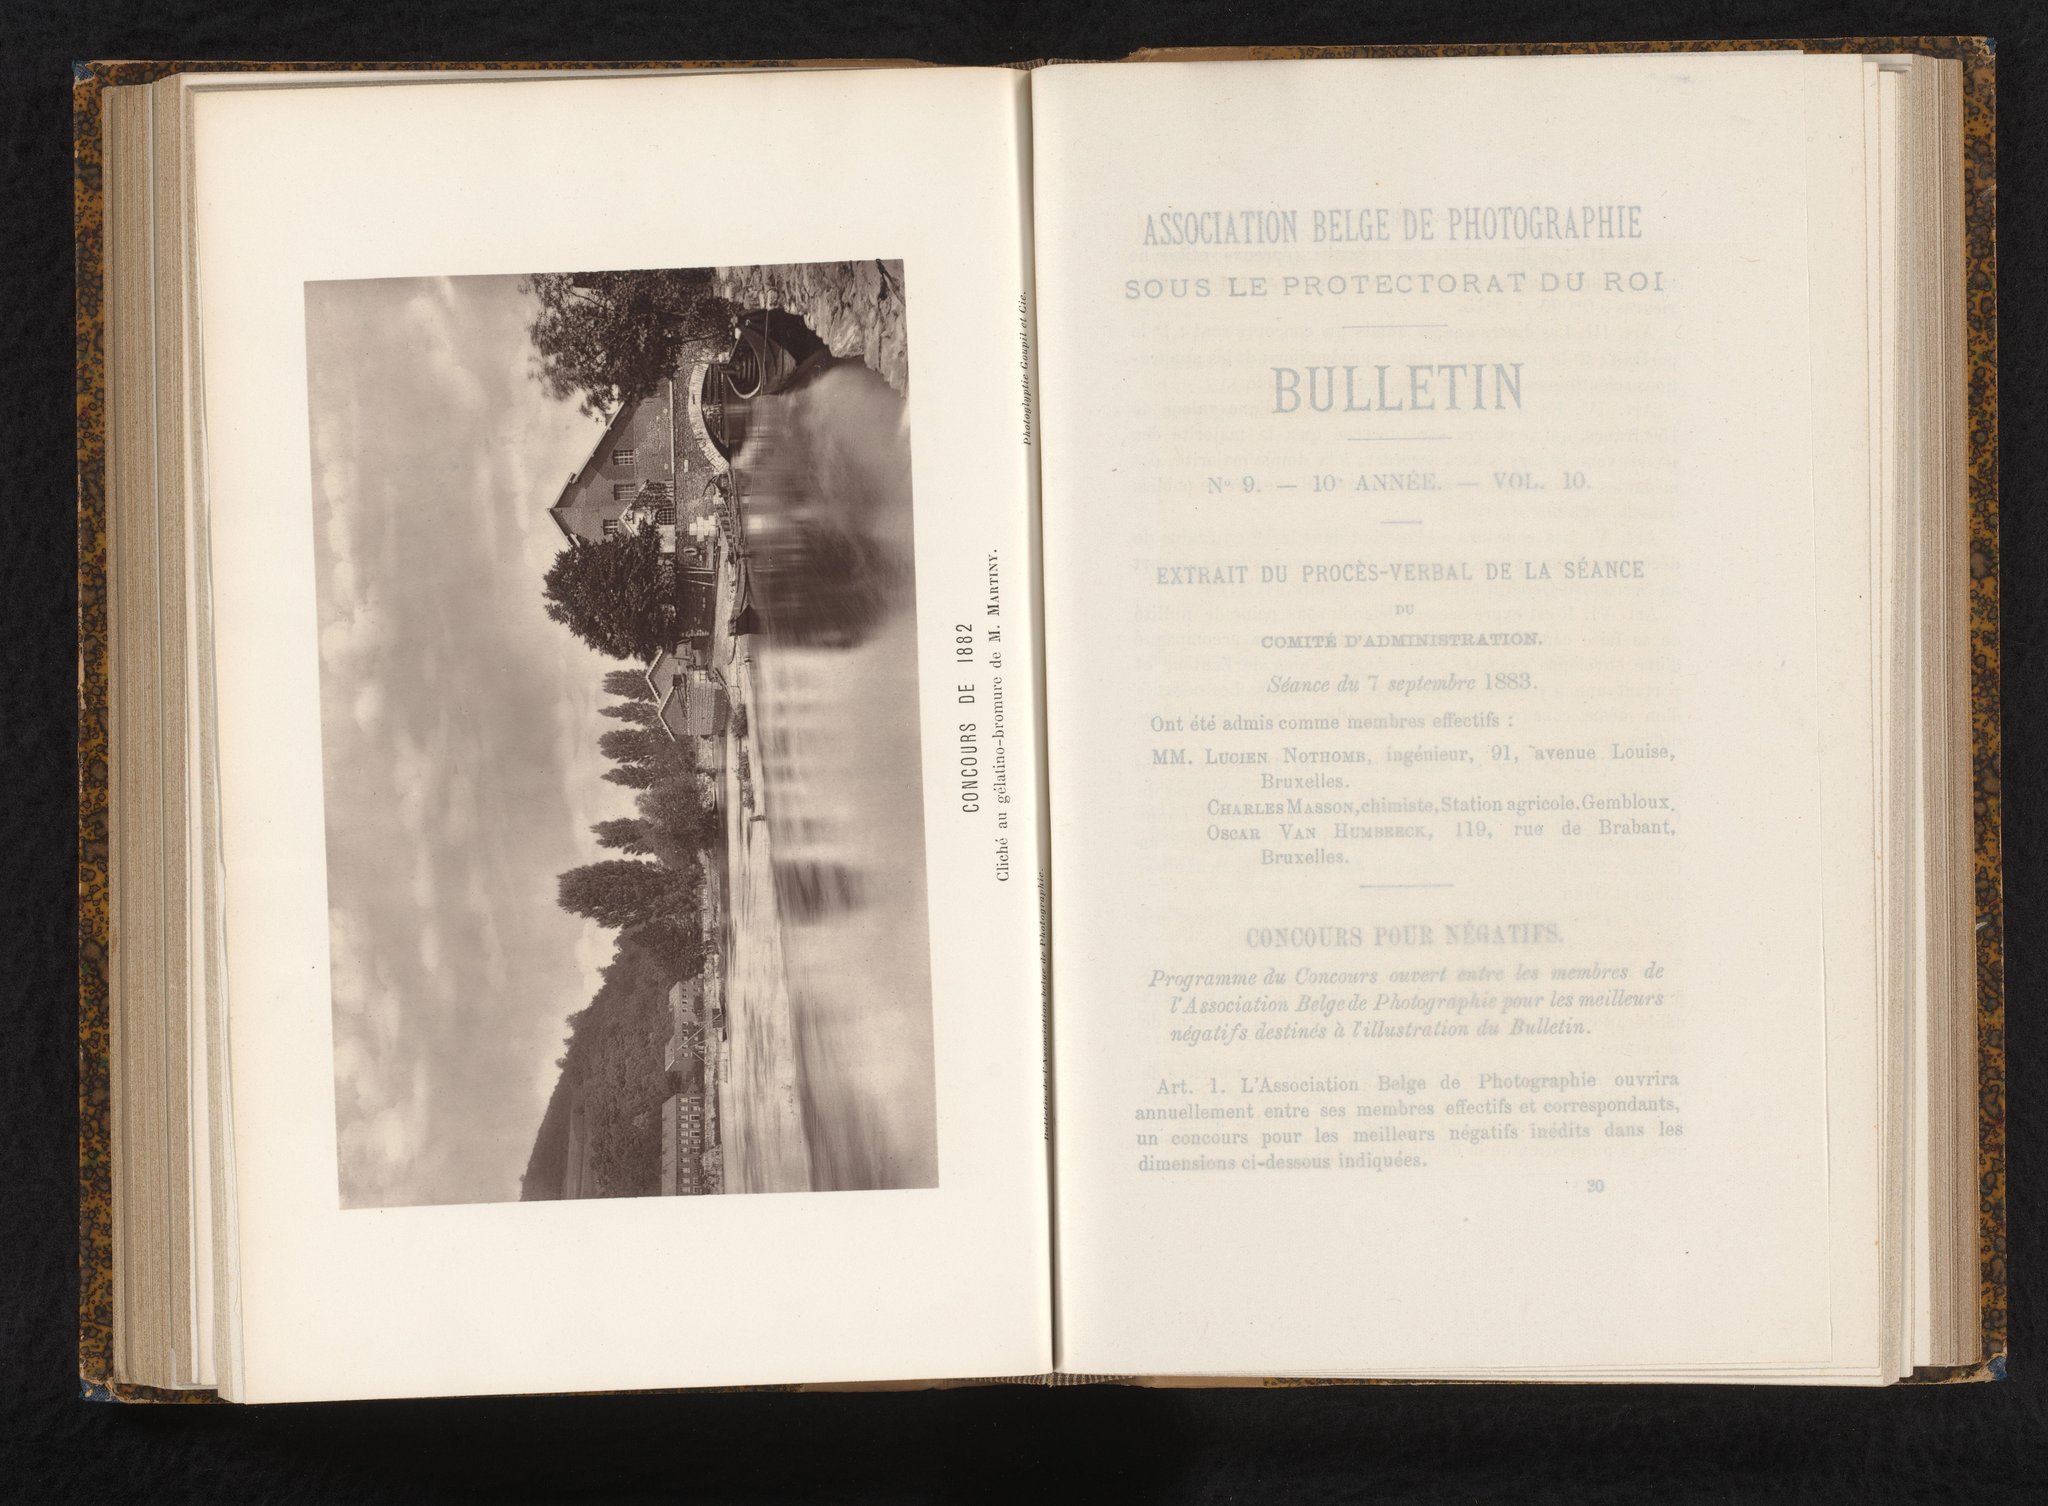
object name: photomechanical print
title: Rivierlandschap nabij Luik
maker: jules martiny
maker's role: fotograaf, koopman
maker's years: 1850-1917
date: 1877-1882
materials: paper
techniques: woodburytype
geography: liège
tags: river, bridge, liège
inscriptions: inscription: ‘Concours de 1882./ Cliché au gélatino-bromure de M. Martiny.’